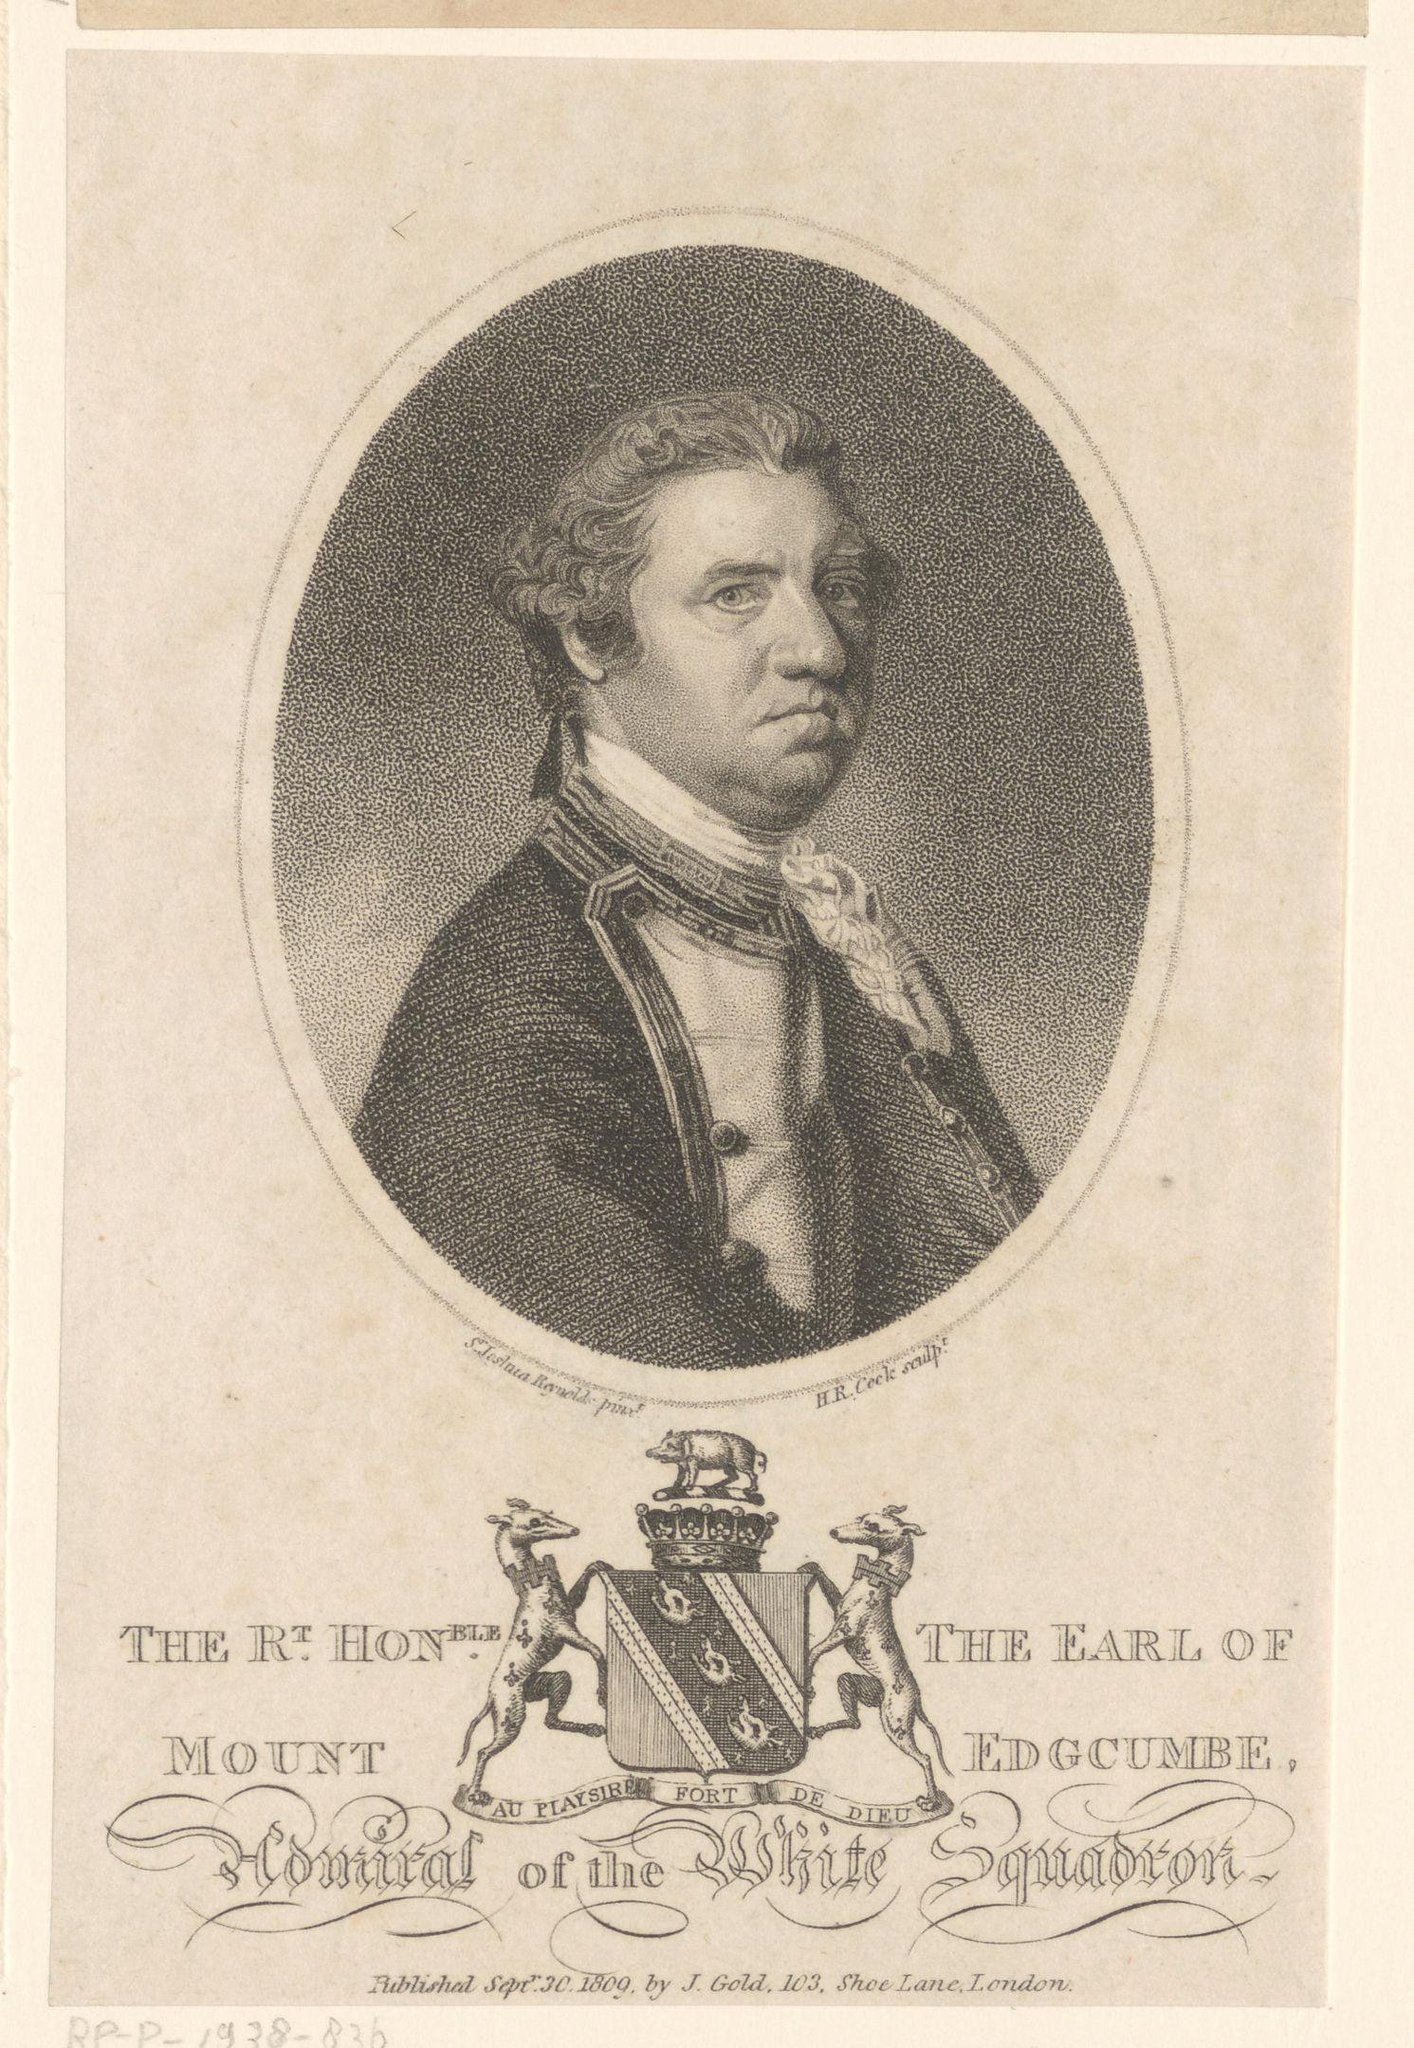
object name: print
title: Portret van George Edgcumbe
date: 1809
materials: paper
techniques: etching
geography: london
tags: historical persons, commander-in-chief, admiral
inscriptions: collector's mark: Lugt 2228